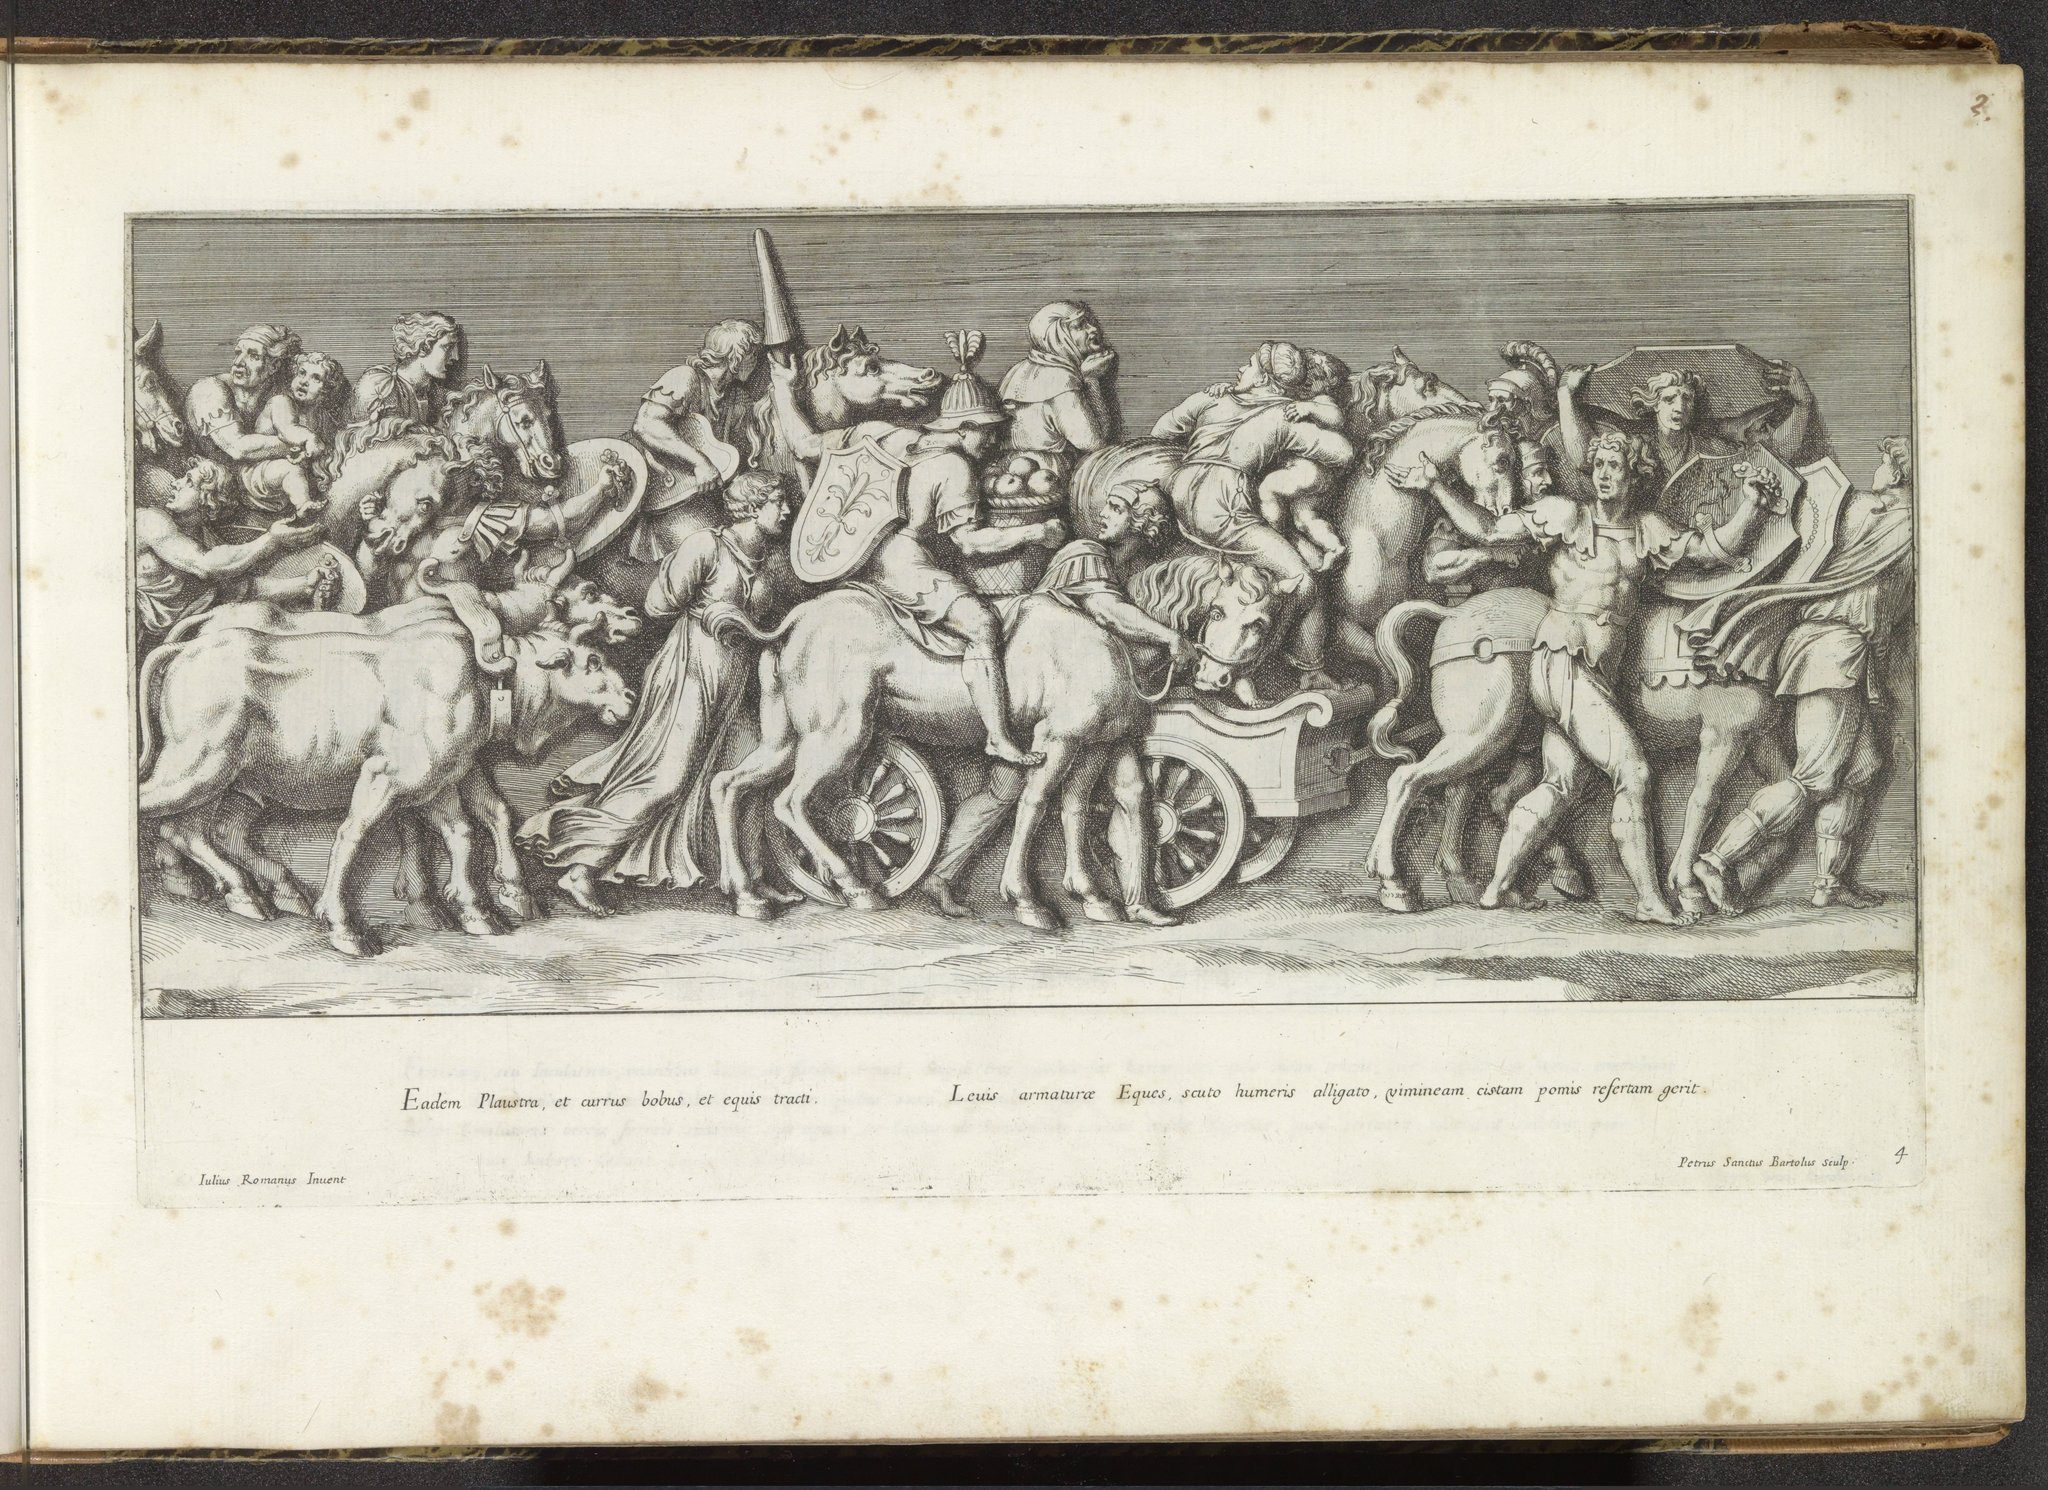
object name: print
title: Stucwerk in de Sala degli Stucchi in Palazzo del Te te Mantua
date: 1680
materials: paper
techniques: etching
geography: vatican city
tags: triumphal entry and public reception, pageant, 'entrée solennelle', 'joyeuse entrée', military parade, pageant, the soldier; the soldier's life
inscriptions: number: ‘4’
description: Prent maakt deel uit van een reeks van 25 prenten (+ titelprent) naar het stucwerk door Giulio Romano en Francesco Primaticcio in de Sala degli Stucchi in Palazzo del Te te Mantua.